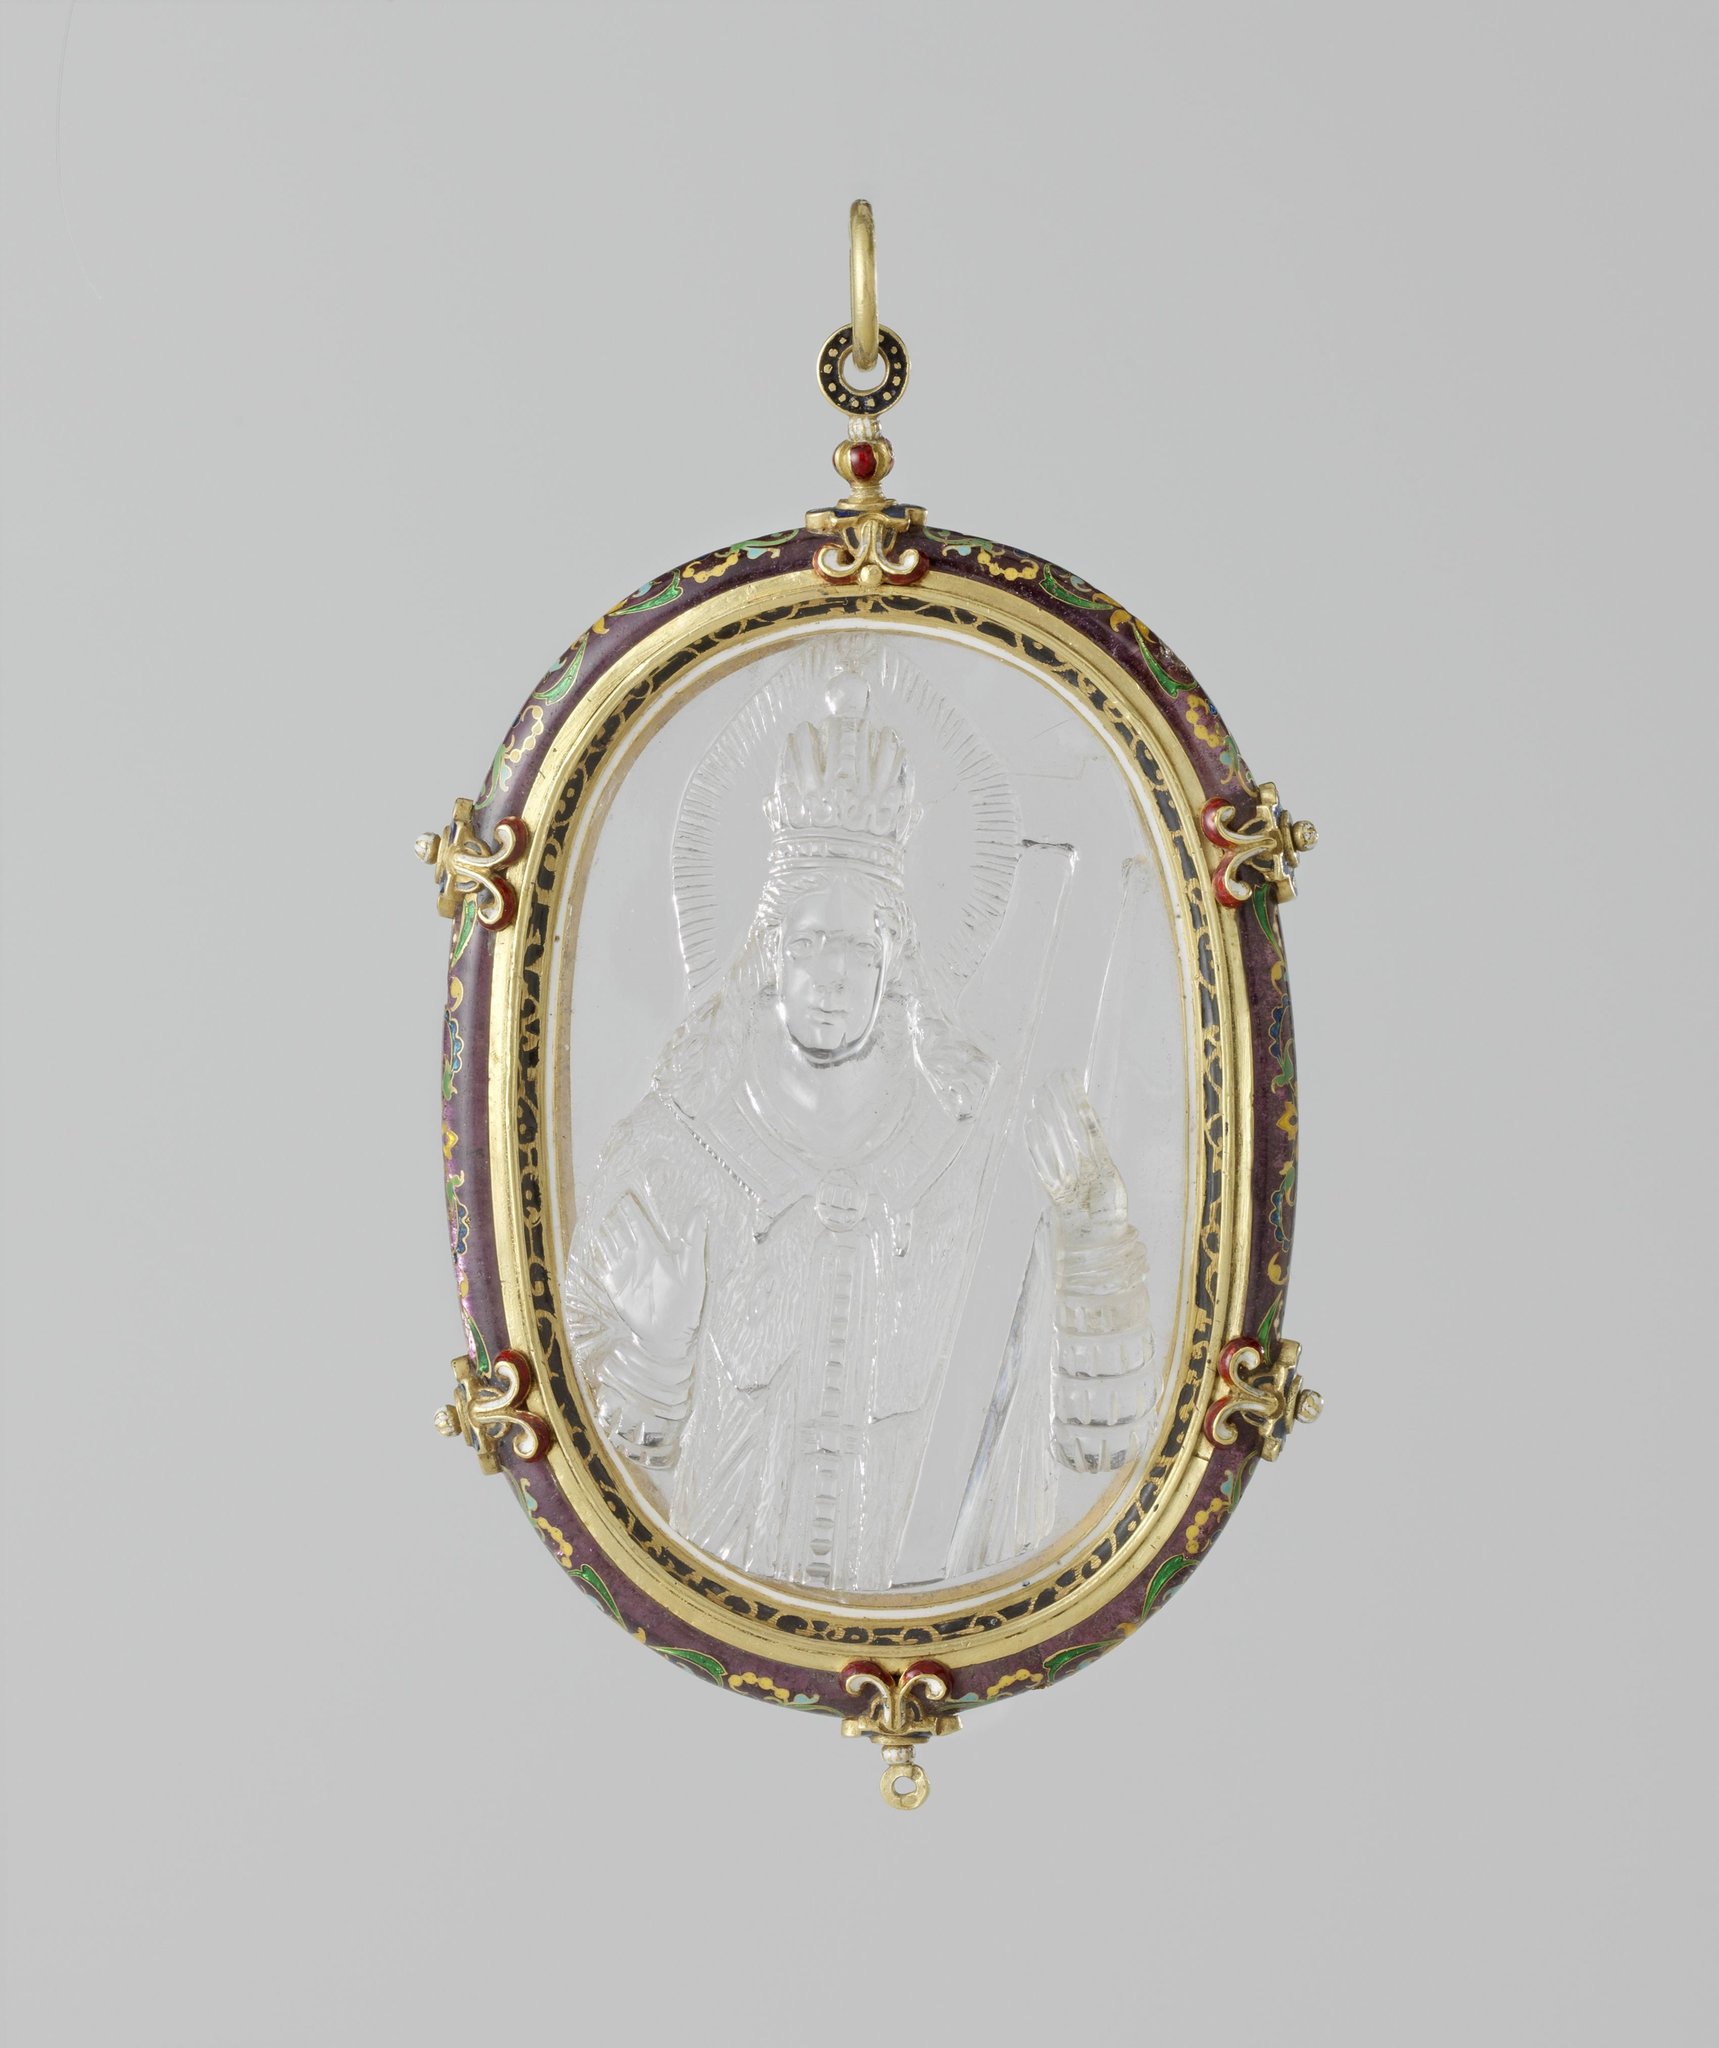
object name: pendant jewelry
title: Medaillon met de H. Helena met kruis en keizerskroon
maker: Anonymous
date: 1200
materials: gold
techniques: enameling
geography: byzantium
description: Medallion with Saint Helena with a cross and an Emperor's crown. Rock crystal, gold, enamel and émail en résille. Spain, c. 1600.